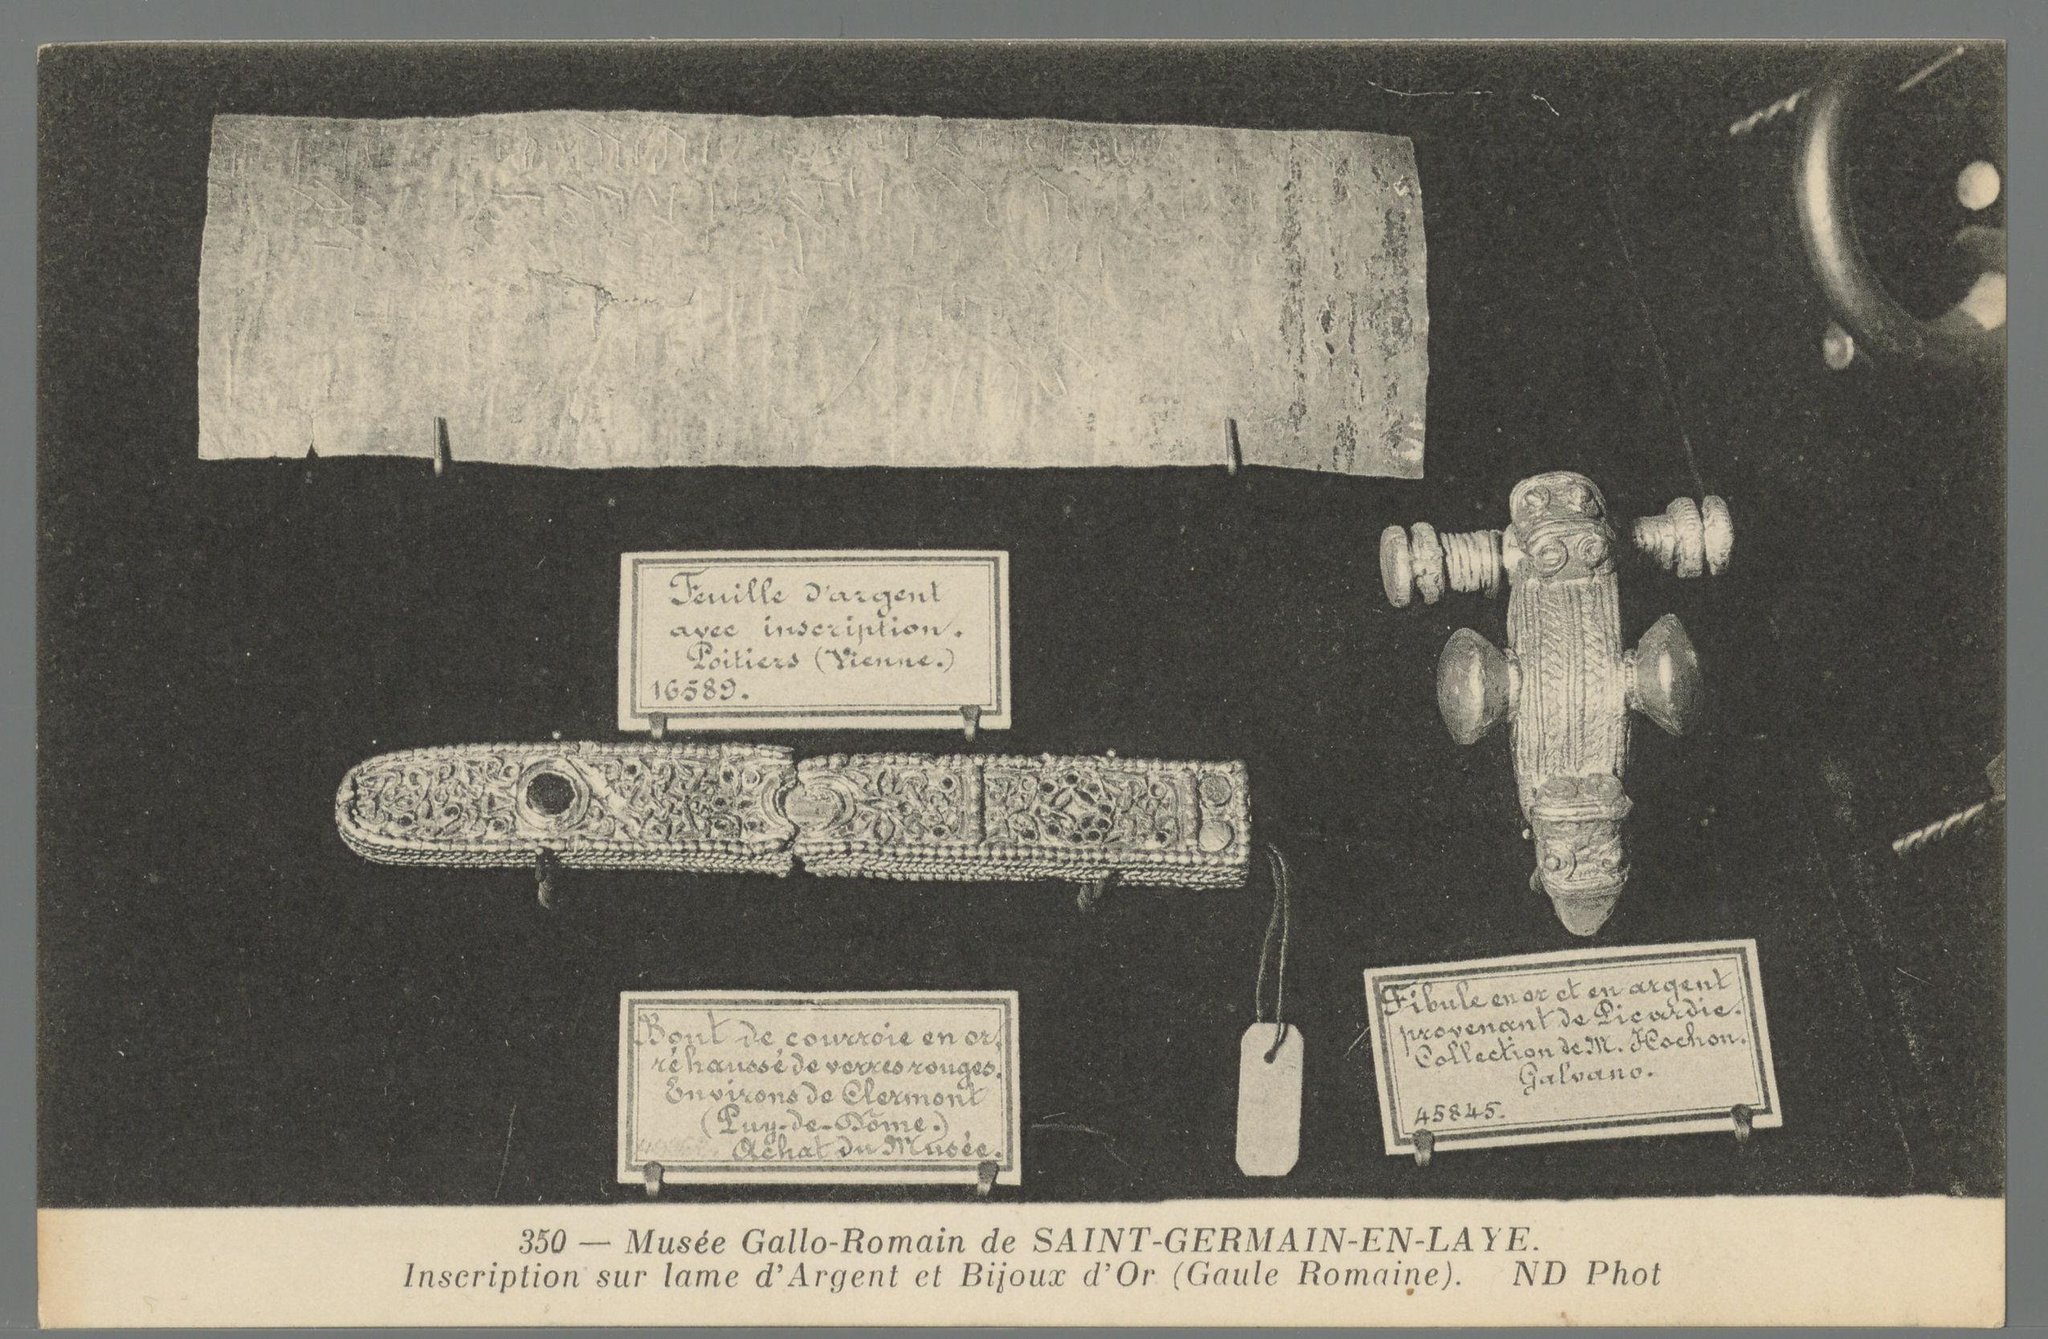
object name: ansichtkaart, prentbriefkaart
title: Inscription sur lame d'argent et bijoux d'or (Gaule Romaine)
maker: Anonymous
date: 1903-1918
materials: cardboard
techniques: photograph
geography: paris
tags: hacking and thrusting weapons, ornaments, jewels, permanent exhibition, museum